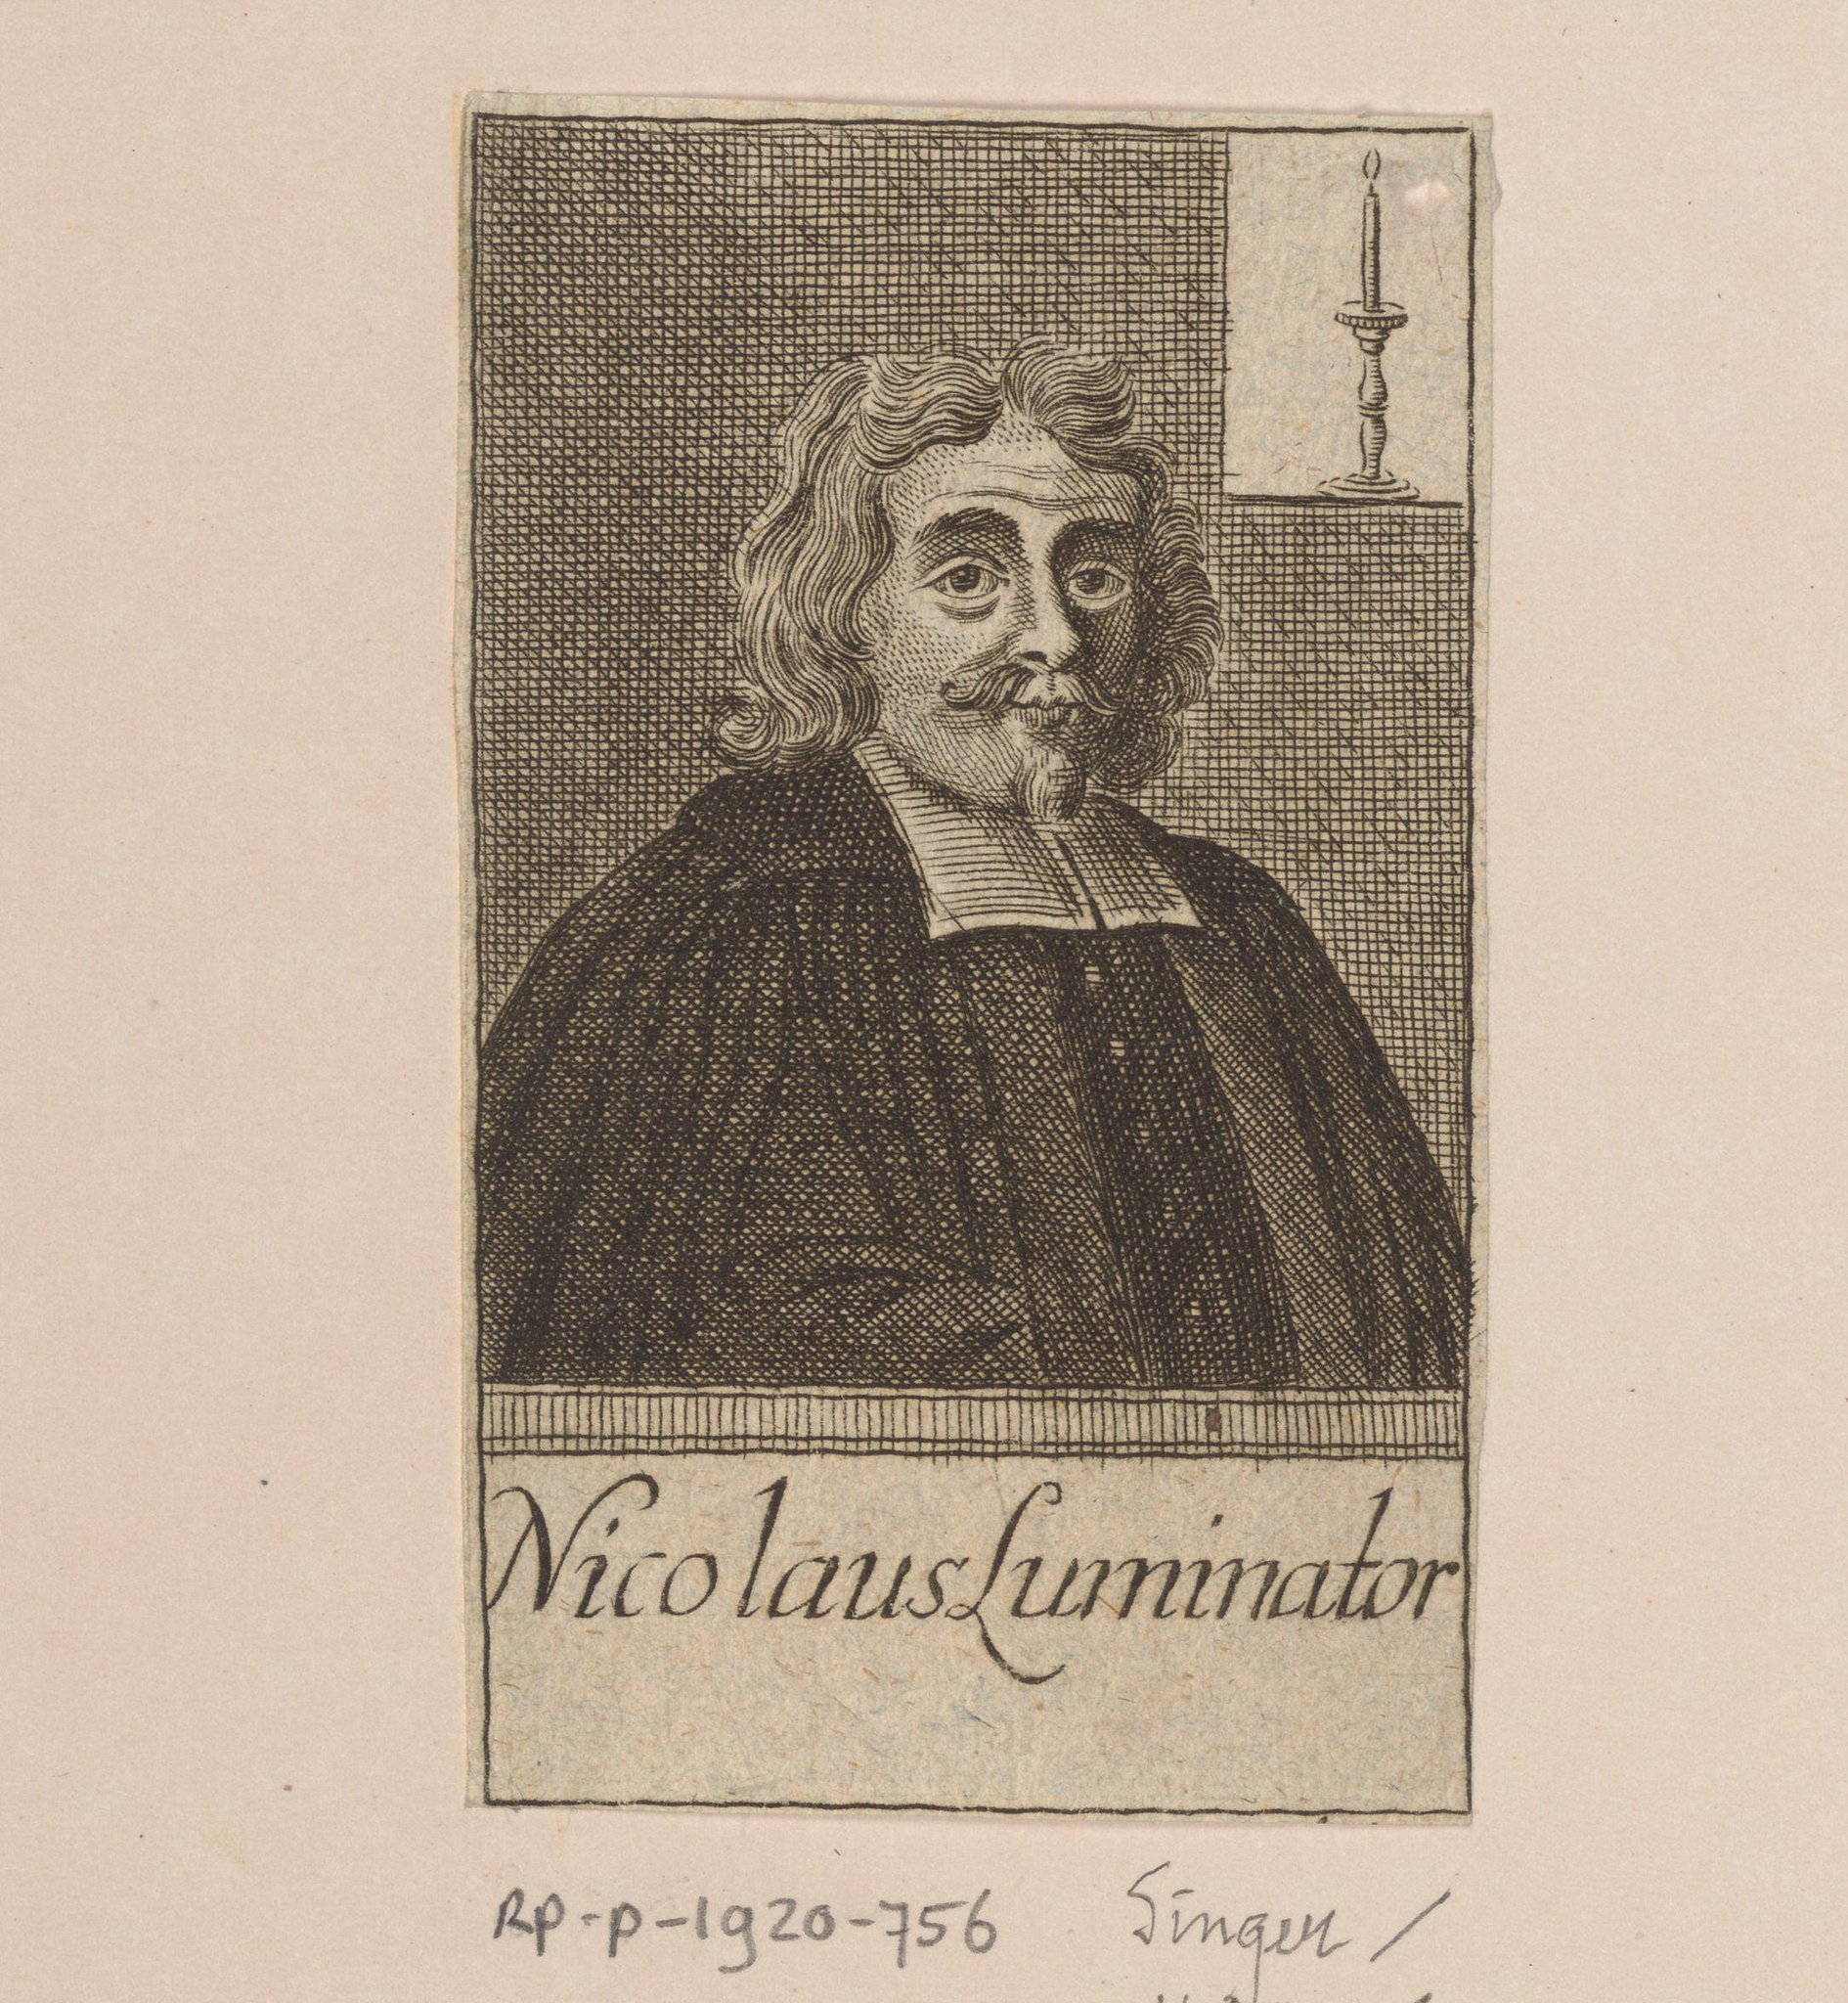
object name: print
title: Portret van Nicolaus Luminator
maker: Anonymous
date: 1700-1799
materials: paper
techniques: engraving, etching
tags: historical persons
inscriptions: collector's mark: Lugt 2228